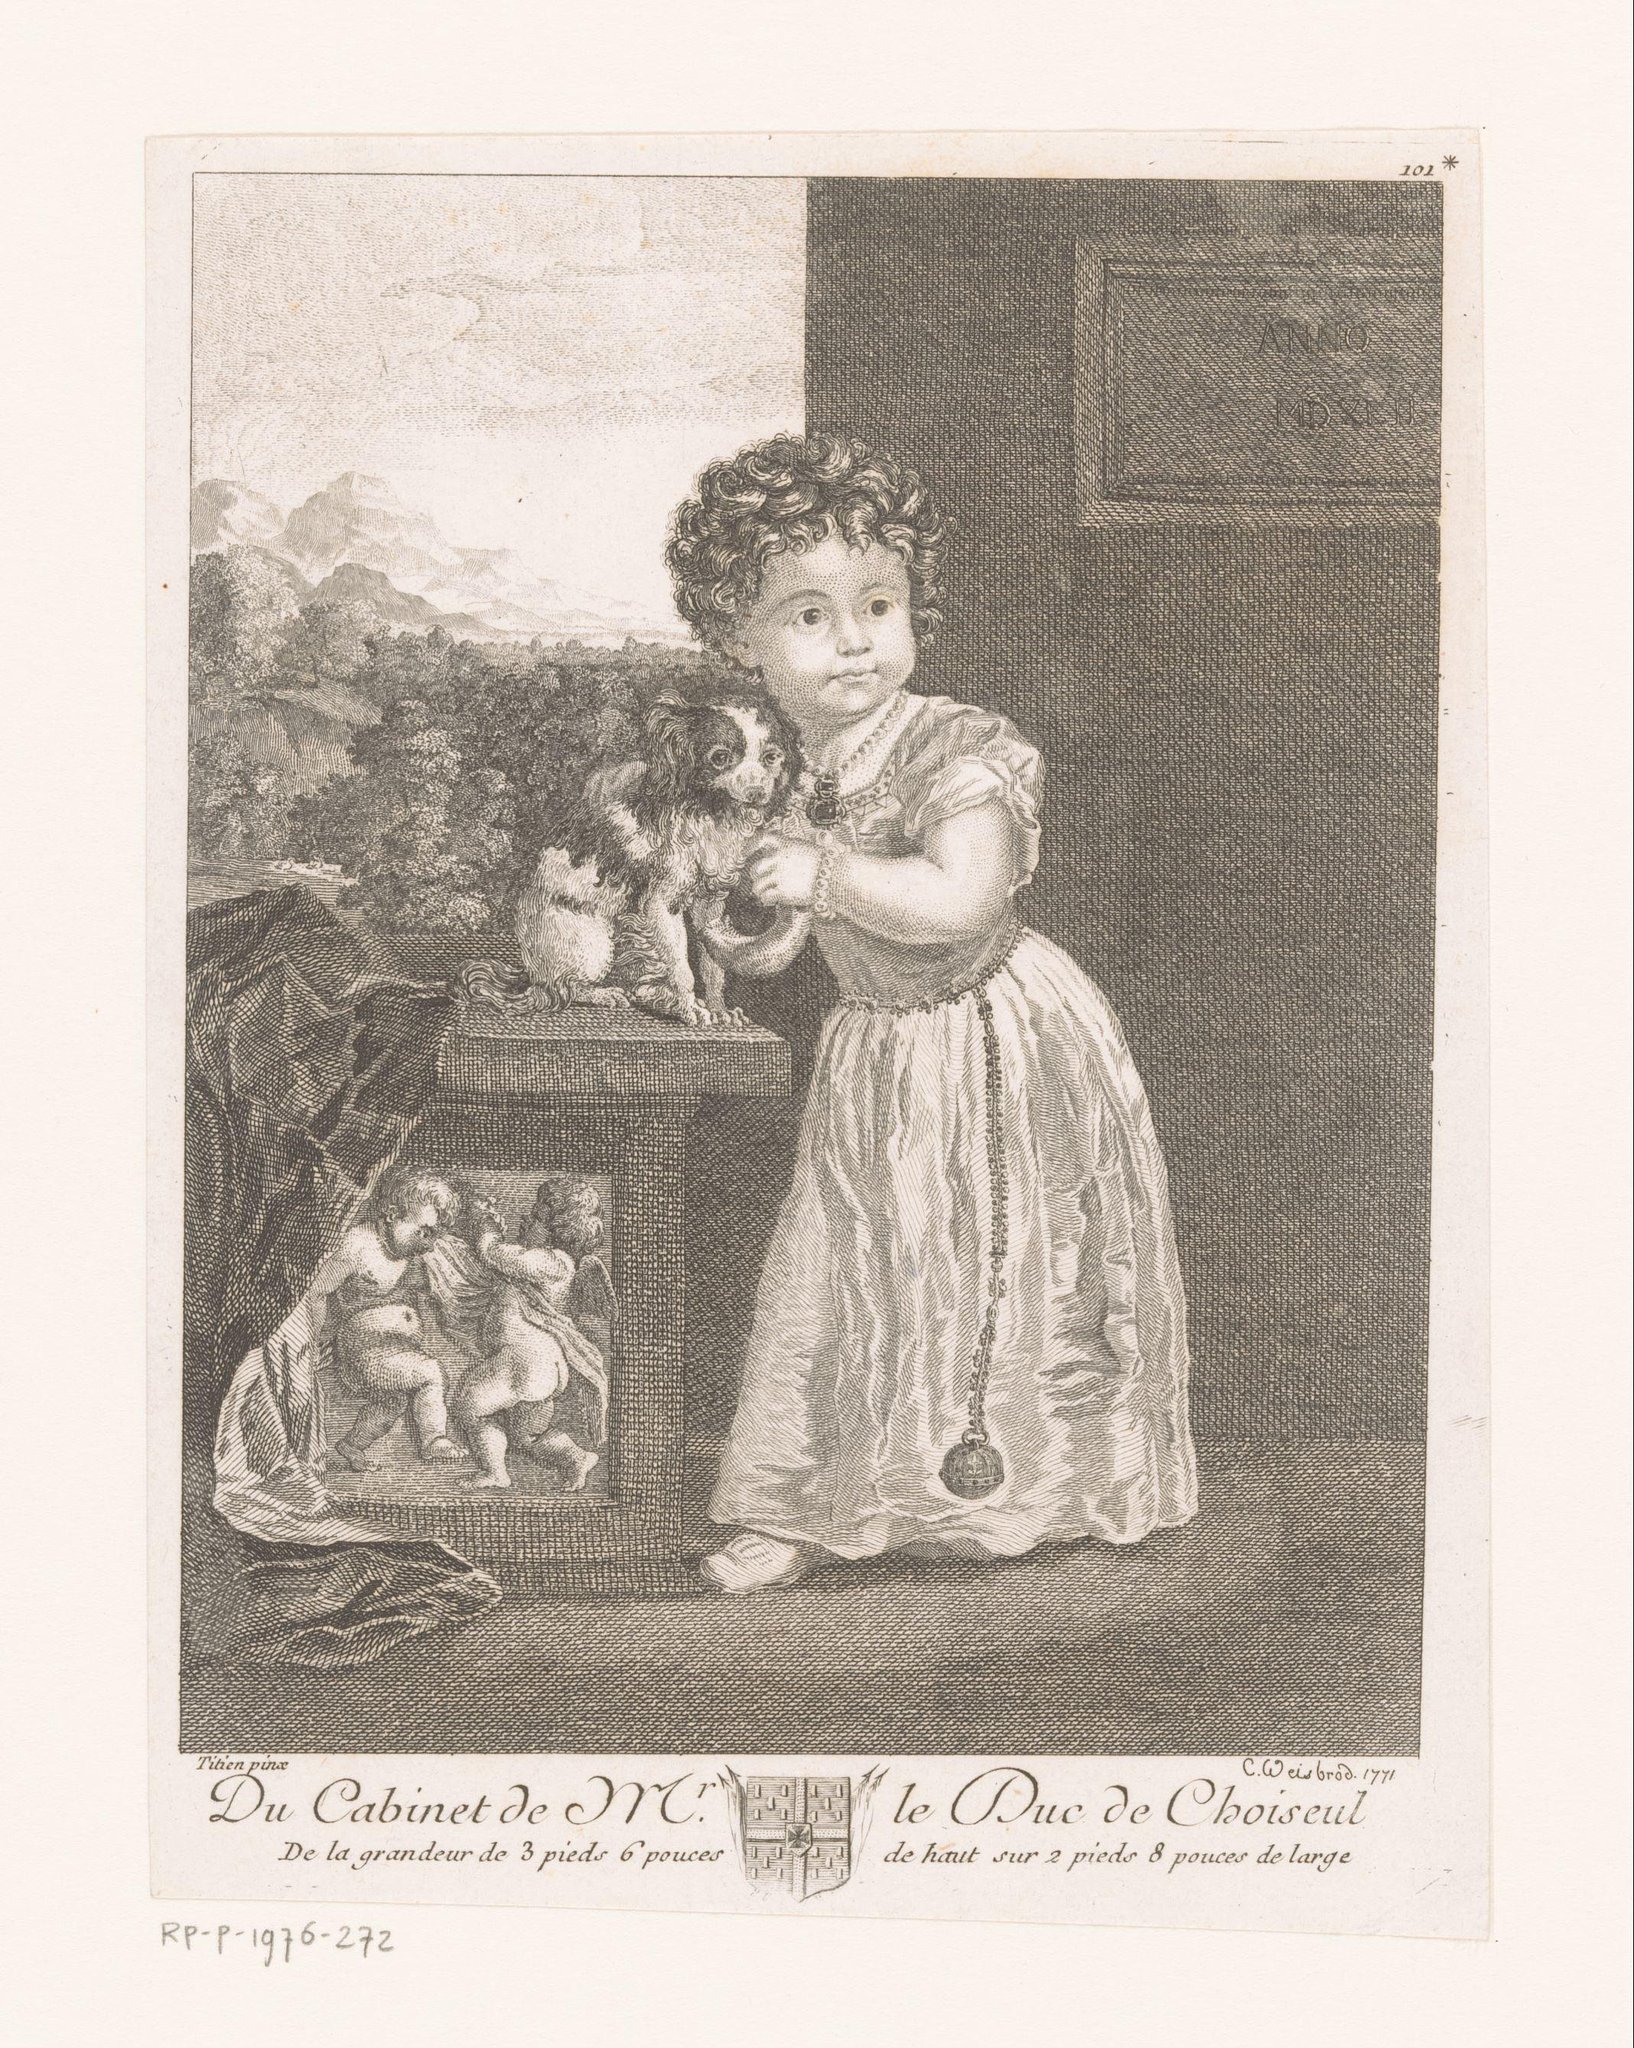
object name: print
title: Portret van Clarissa Strozzi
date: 1771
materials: paper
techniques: etching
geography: paris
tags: landscapes, historical persons, dog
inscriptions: collector's mark: Lugt 2228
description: Prent naar het schilderij door Titiaan in de Gemäldegalerie te Berlijn.